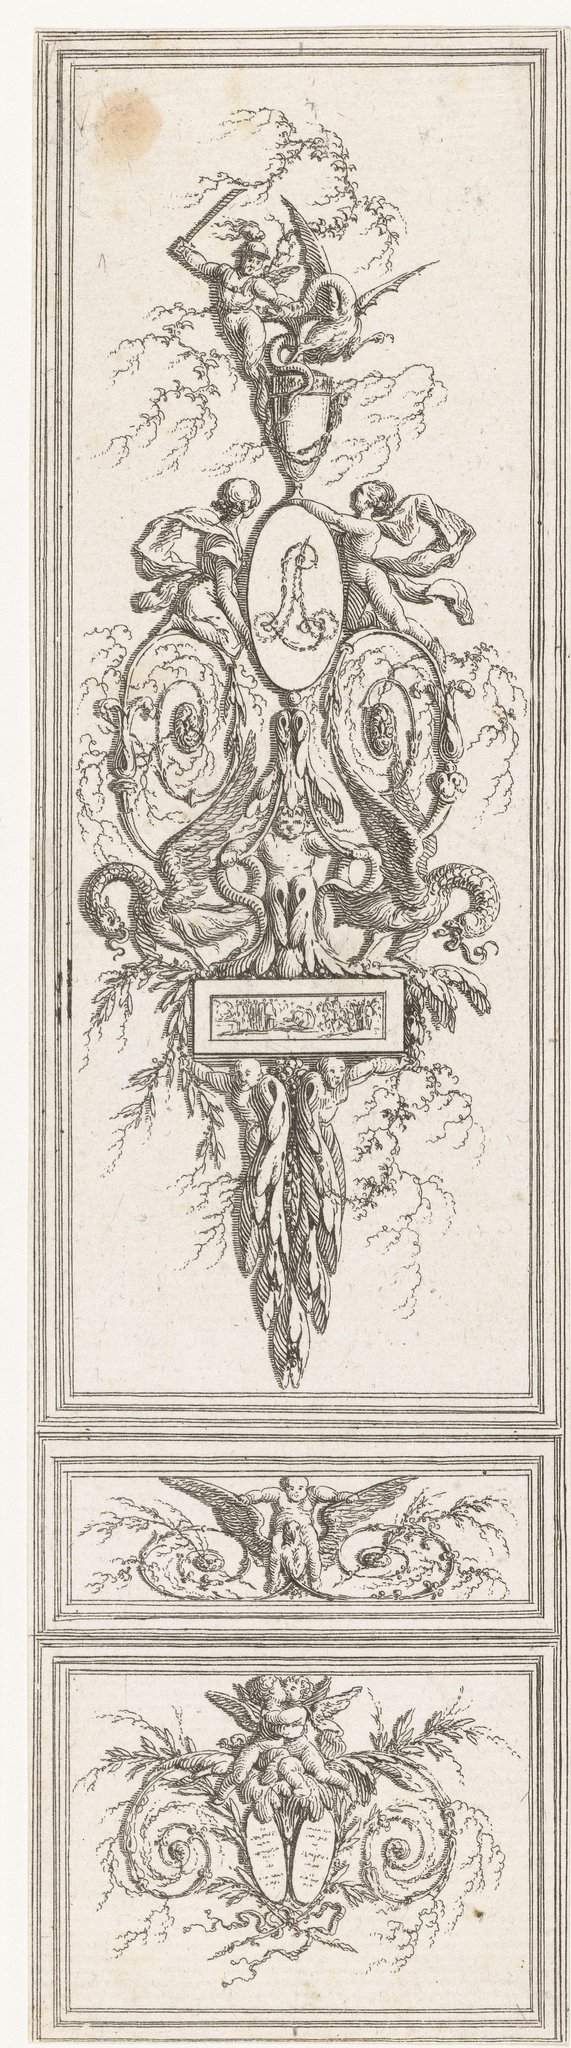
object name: ornament print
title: Decoratie voor deur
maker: Anonymous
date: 1763-1820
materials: paper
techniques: etching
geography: france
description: Drie panelen, in het bovenste zitten twee figuren op voluten van bladranken naast een ovaal met een monogram (LA?).